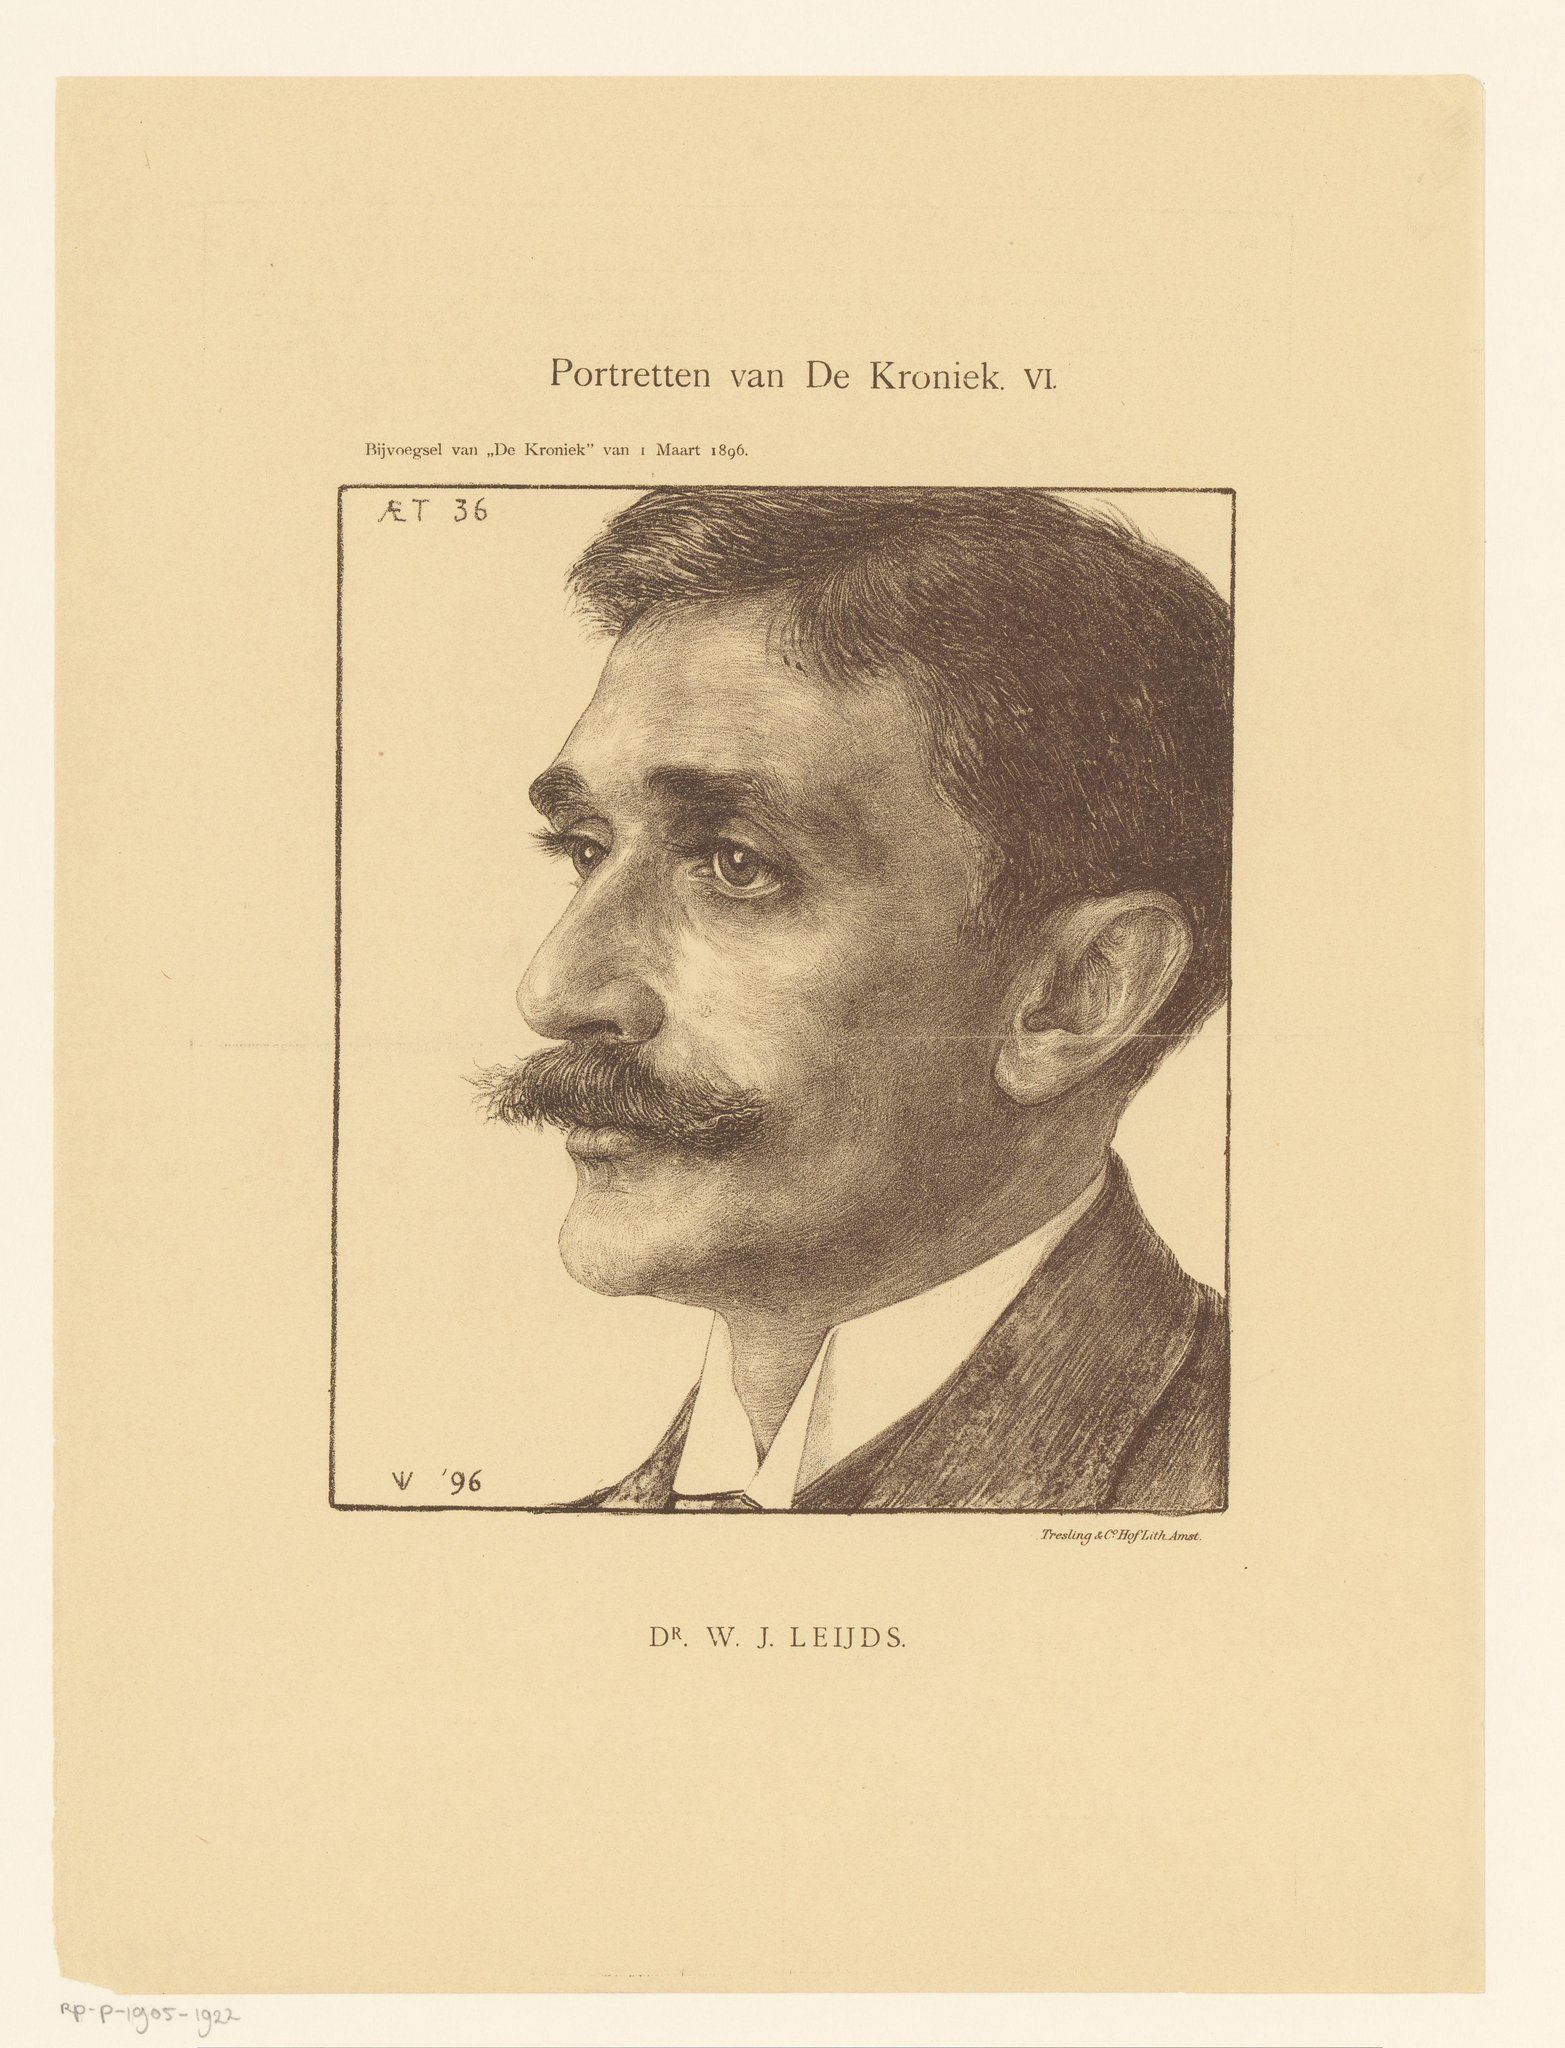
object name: print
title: Portretten van De Kroniek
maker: jan veth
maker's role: designer, draughtsman, painter, print maker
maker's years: 1864-1925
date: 1896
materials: paper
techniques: lithograph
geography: amsterdam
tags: historical persons (+ (full) bust portrait)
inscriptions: collector's mark: Lugt 2228